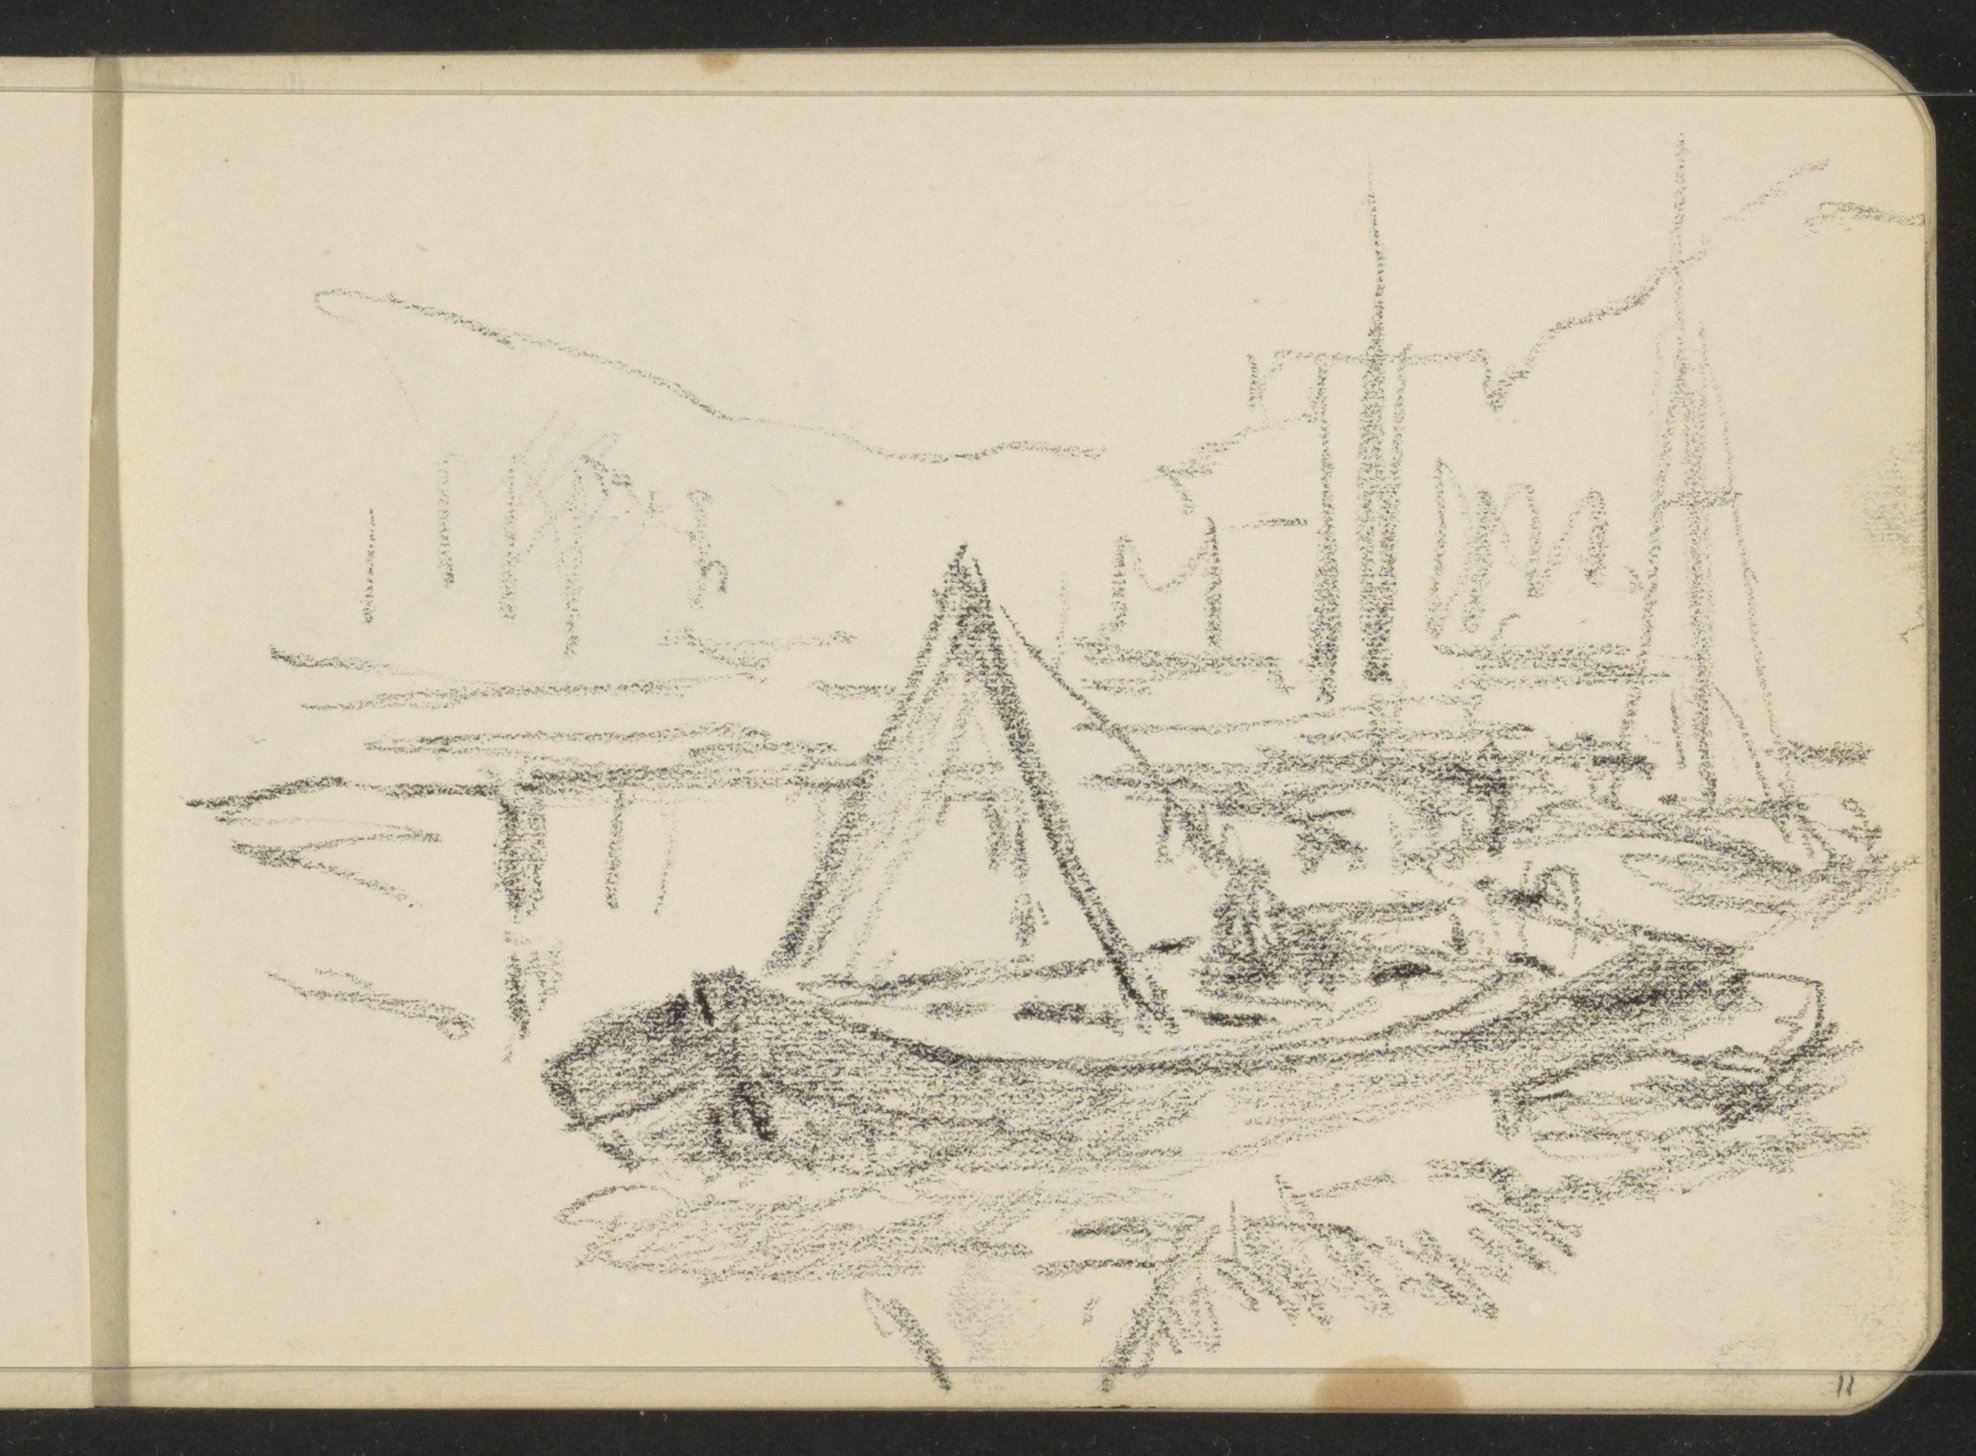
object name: sketchbook leaf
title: Aangemeerde roeiboot aan een kade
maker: willem cornelis rip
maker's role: draughtsman, painter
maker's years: 1856-1922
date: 1914-1916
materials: chalk, paper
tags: rowing-boat, canoe, etc., pier, quay, wharf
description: Blad 11 recto uit een schetsboek met 41 bladen.